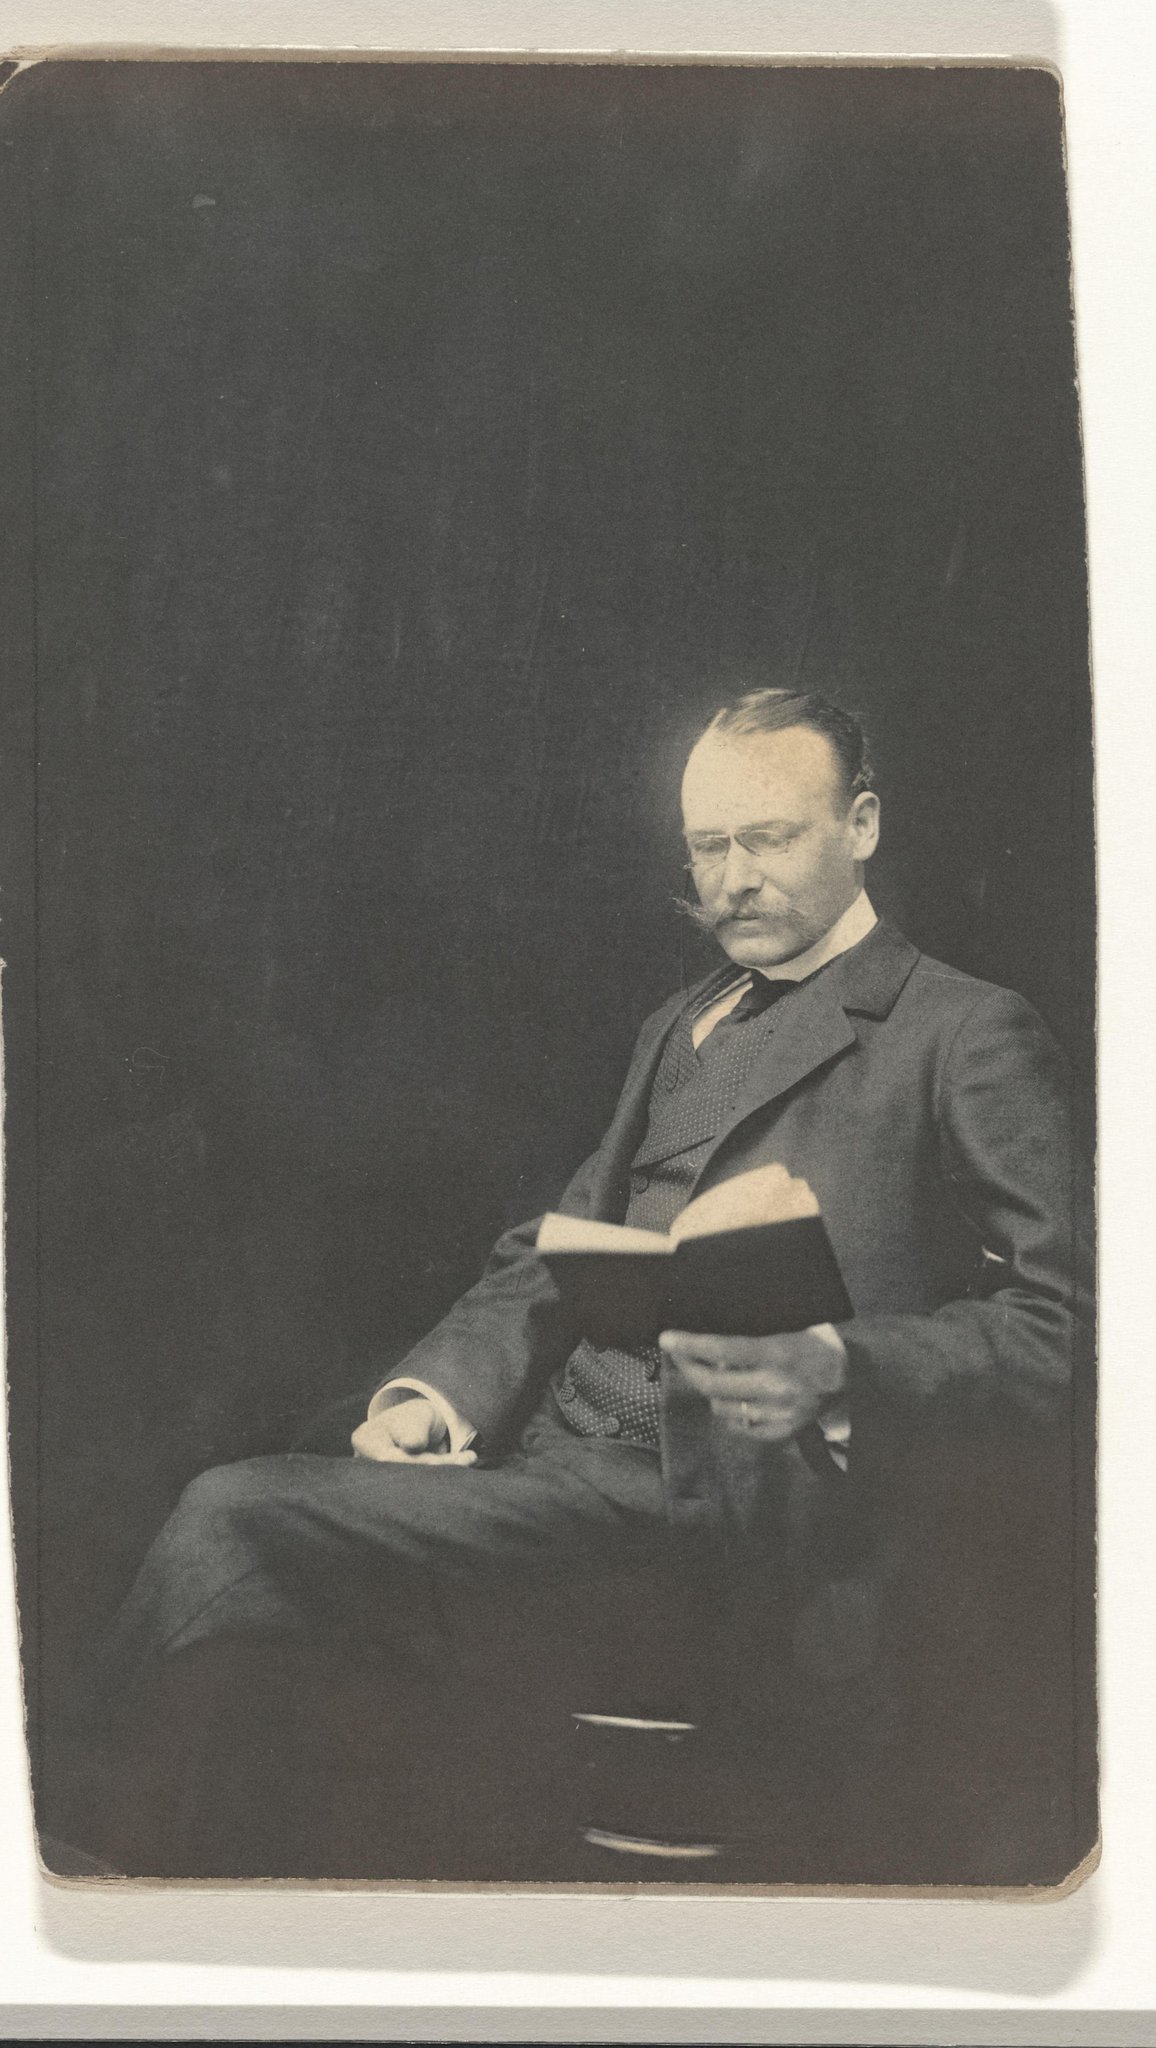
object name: photograph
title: Julius Moos leest een boek, gezeten in een stoel, met een boek in zijn ene hand en de andere hand in zijn schoot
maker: Anonymous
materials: photographic support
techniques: gelatin silver print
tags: julius moos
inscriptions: inscription: ‘Meinen lieben mann Julios Moos ... ... ... an den Winter 1900/1901 ... morgenster’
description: Julius Moos leest een boek, gezeten in een stoel, met een boek in zijn ene hand en de andere hand in zijn schoot.